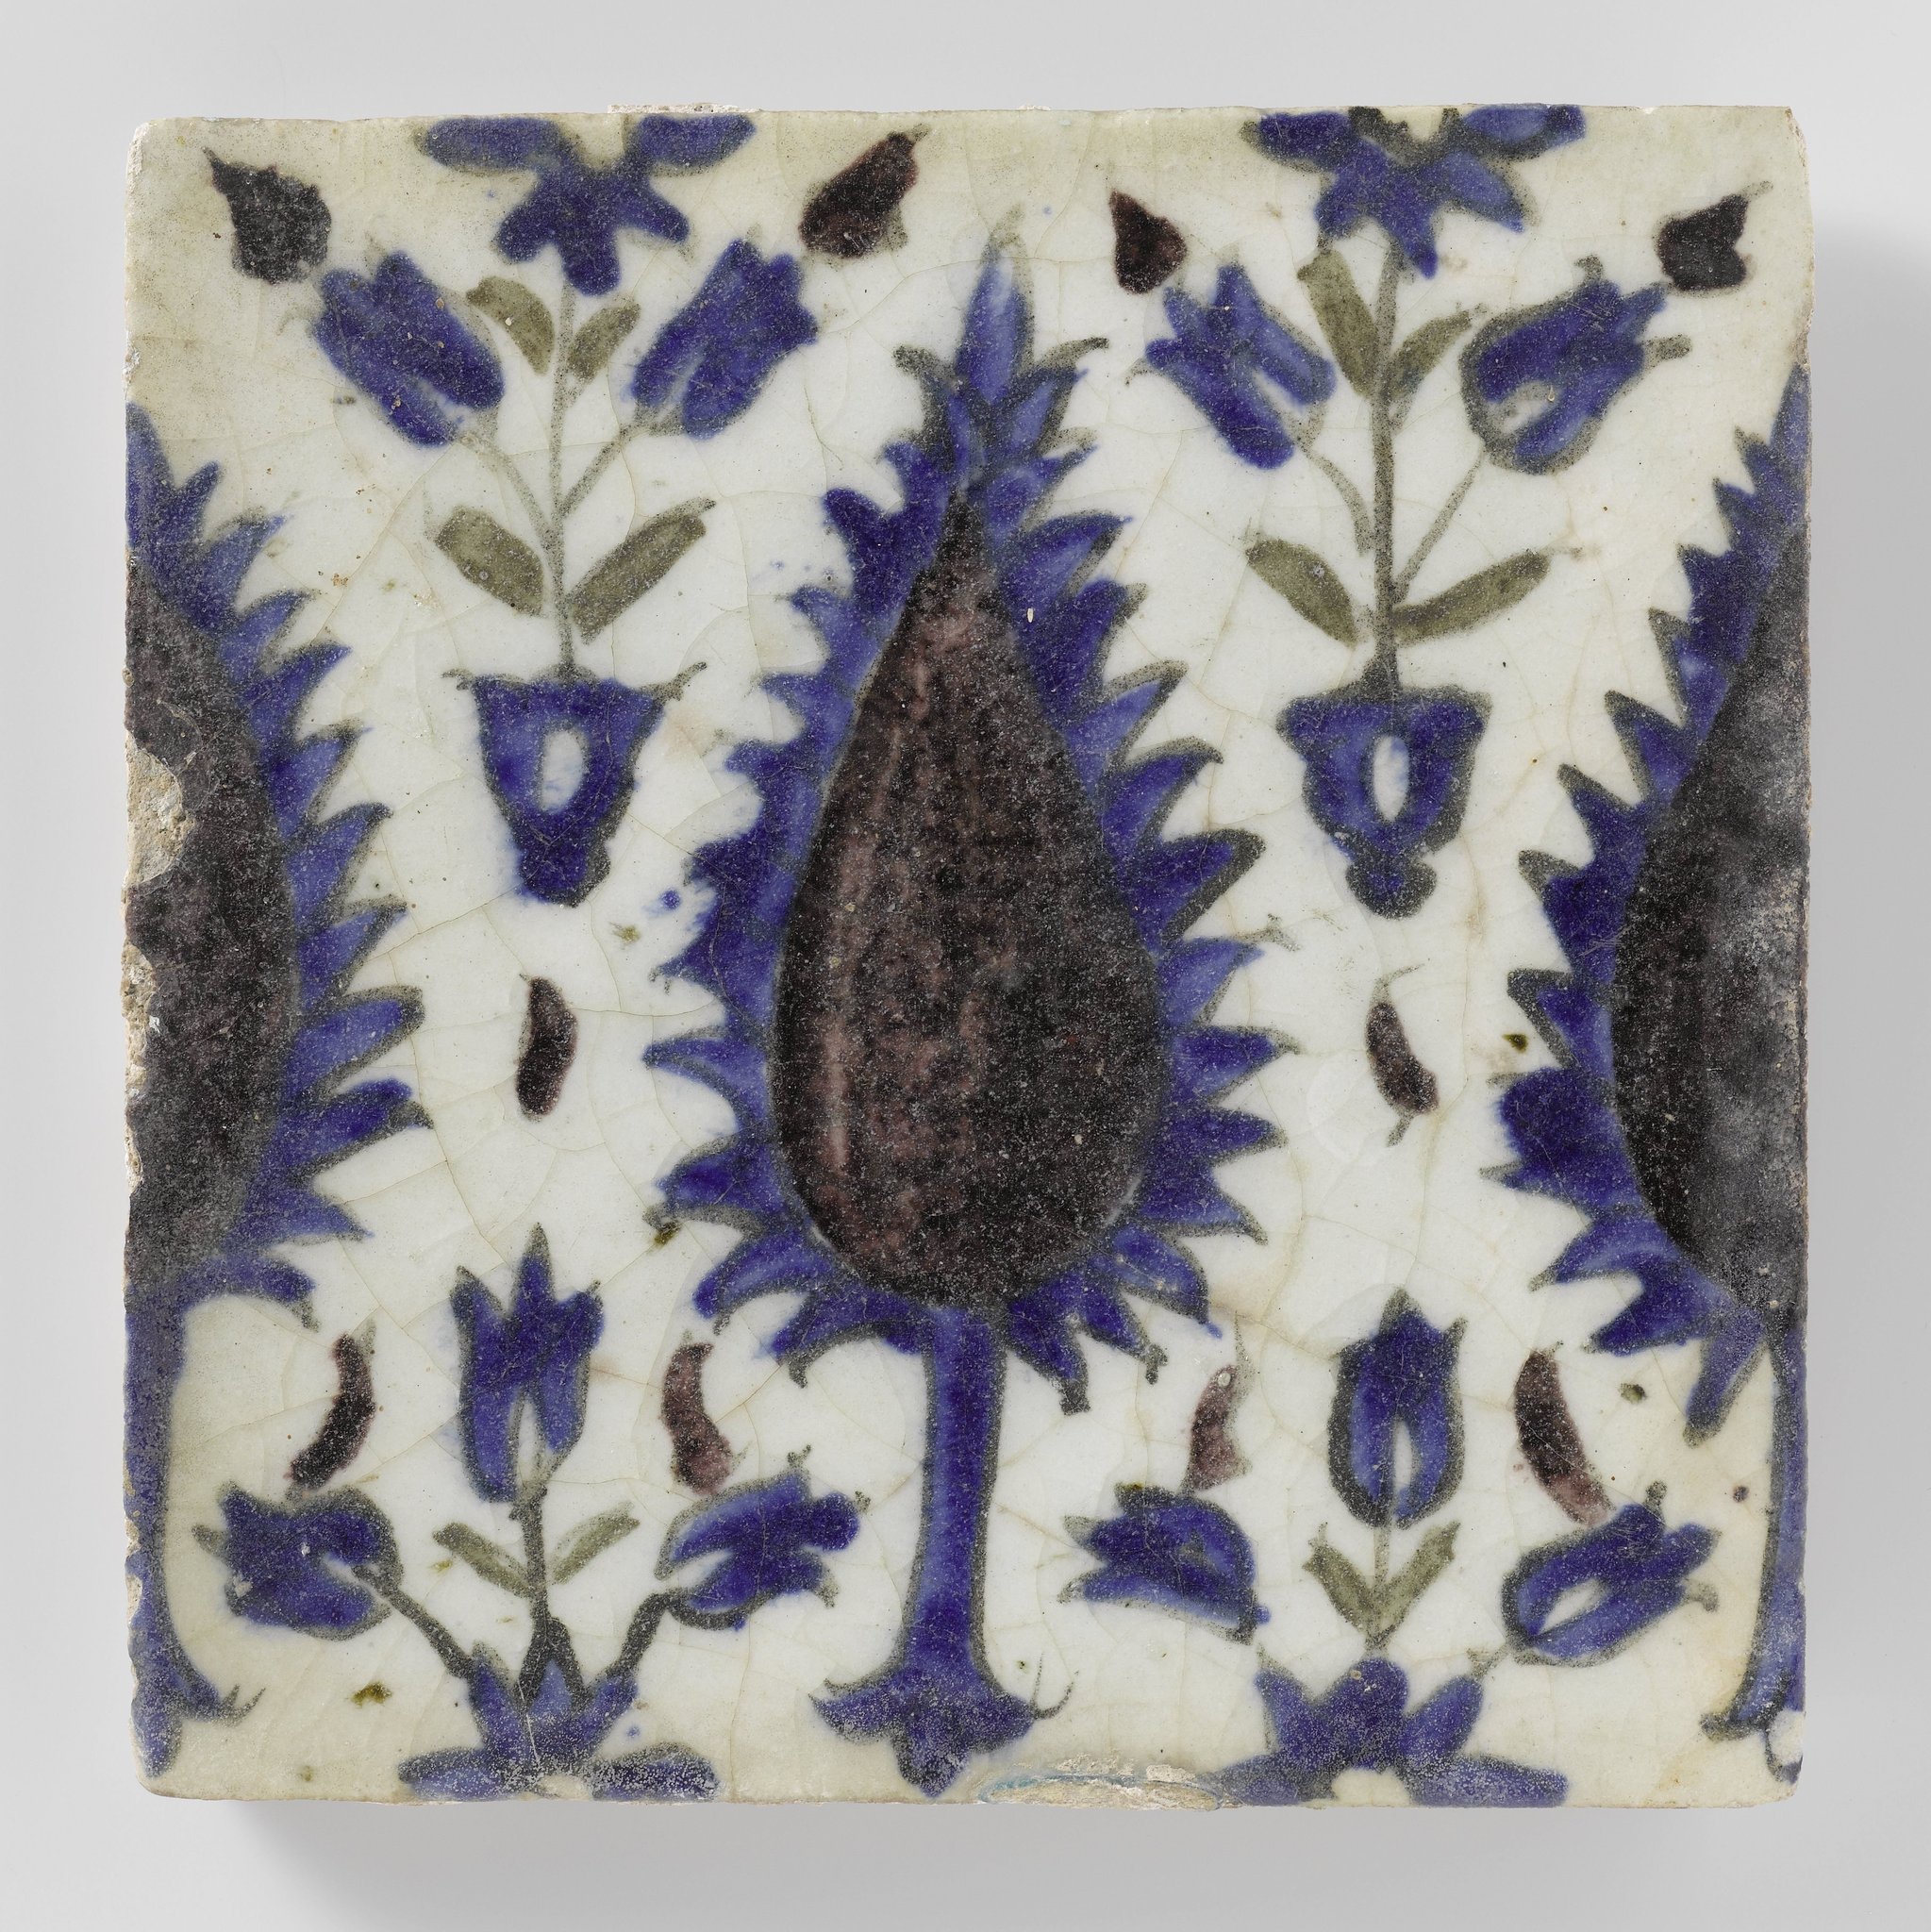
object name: tile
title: Tile with trees and flower sprays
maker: Anonymous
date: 1700-1799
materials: cobalt, earthenware, glaze, paint, quartz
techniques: firing, forming, vitrification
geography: syria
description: Tegel van kwarts-fritgoed, beschilderd met bomen (cipres?) en bloemtakken.